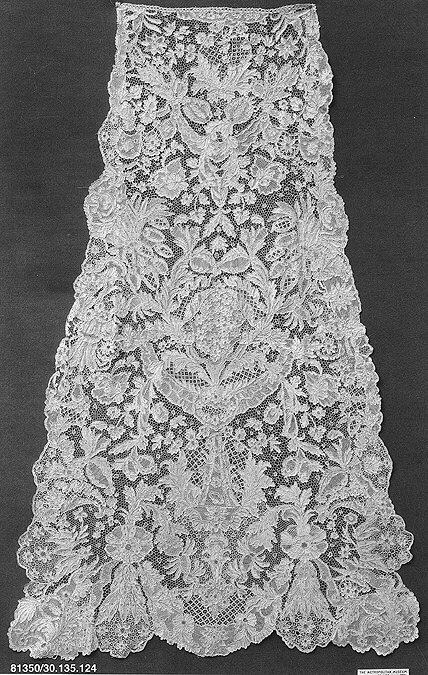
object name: panel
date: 1667-1700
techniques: lace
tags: flowers